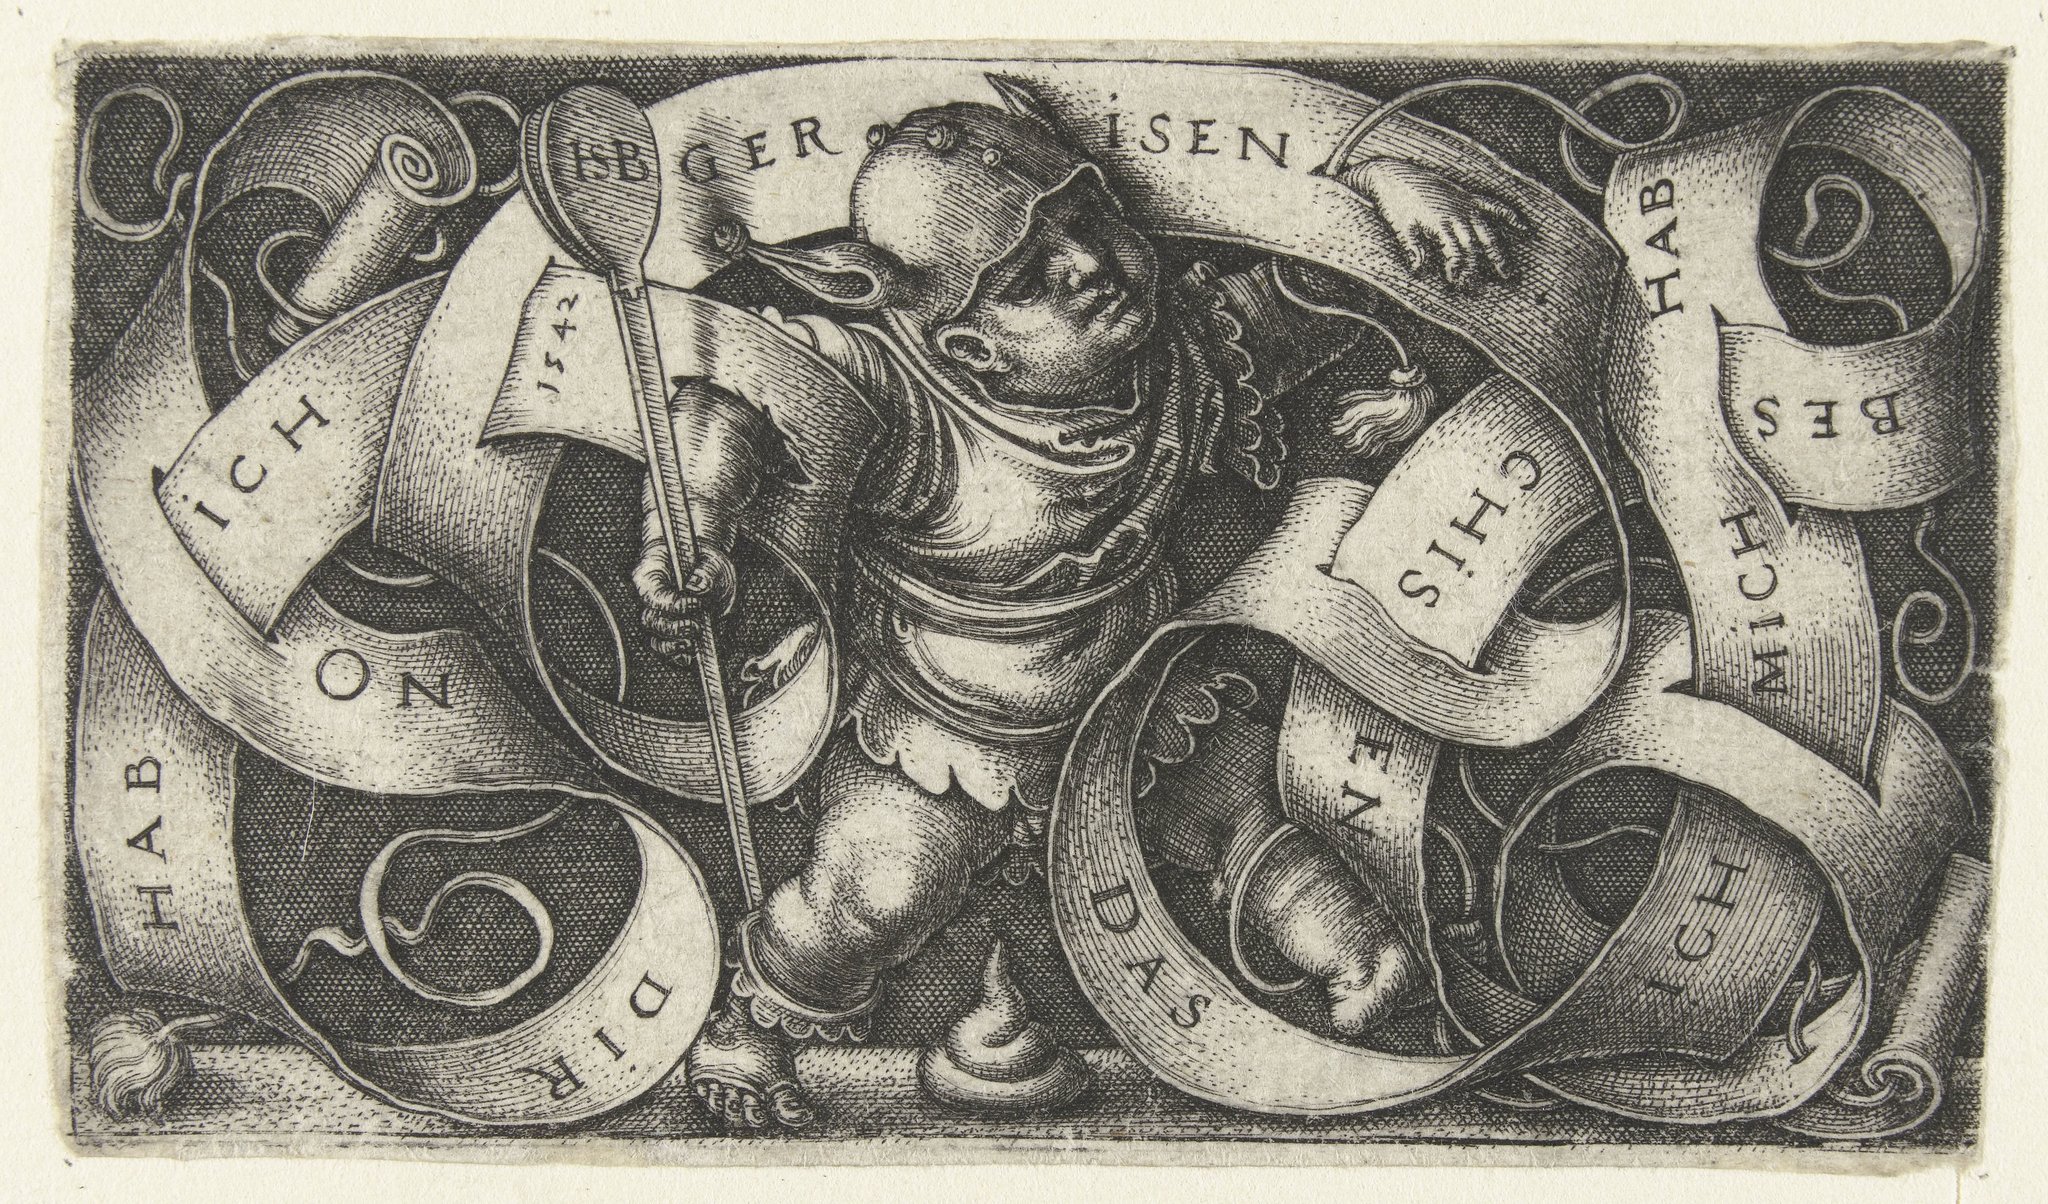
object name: print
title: Vlakdecoratie: een nar met een banderolle met tekst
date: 1510-1542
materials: paper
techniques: engraving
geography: germany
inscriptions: inscription: ‘+ expl. Hinl.’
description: Inscriptie op banderol: MIT DIR HAB ICH 1542 GER ISEN DAS ICH MICH HAB BES CHIS EN. Gearceerde achtergrond.